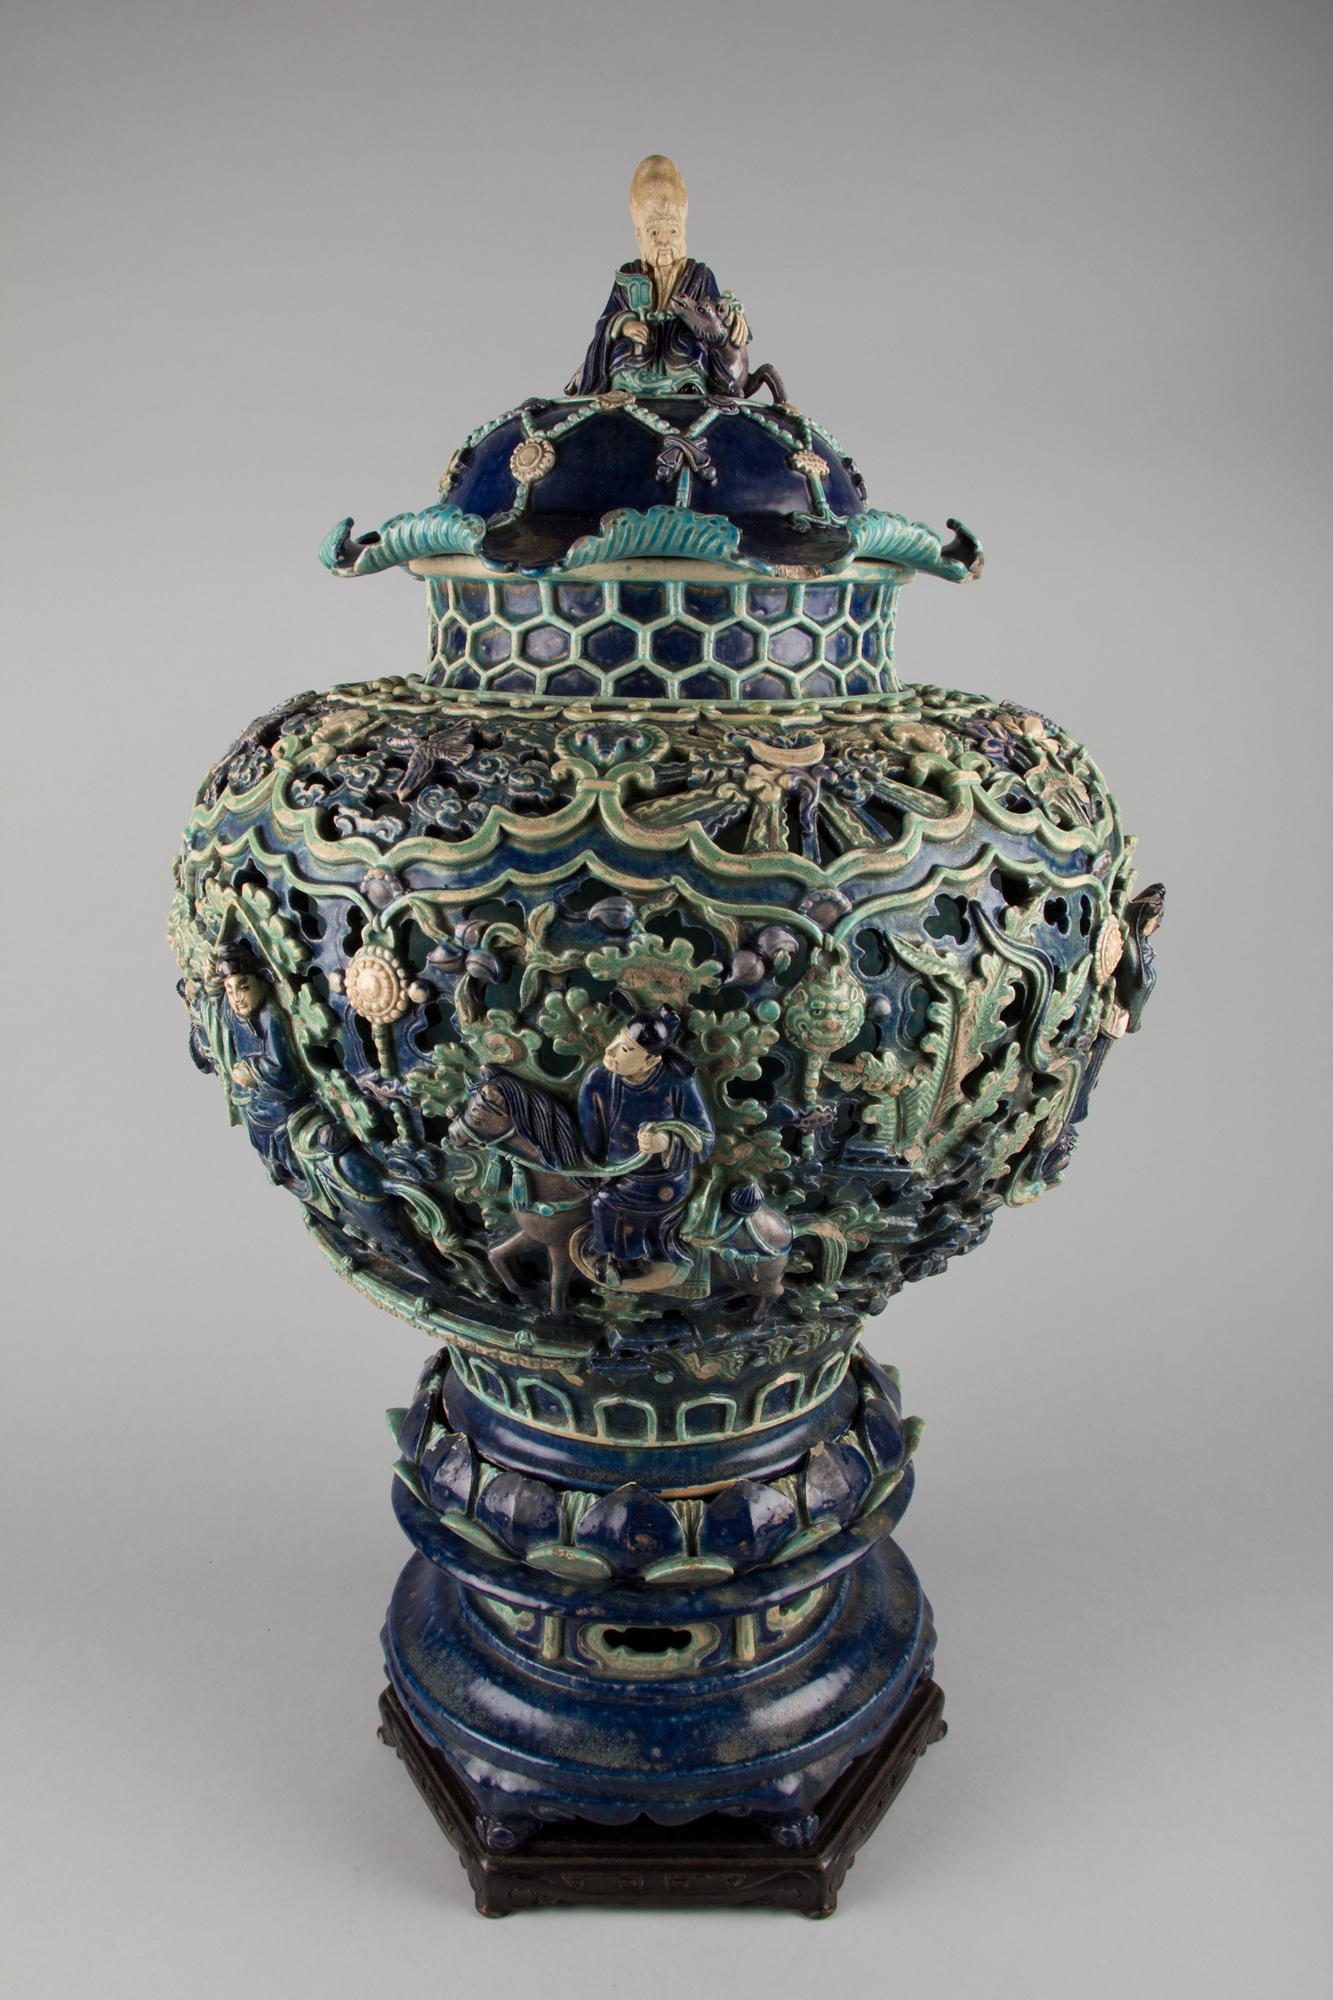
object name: jar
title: Covered Jar on a Pedestal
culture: chinese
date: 1501-1600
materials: biscuit, glaze, stoneware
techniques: carving, relief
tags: men,horses,leaves